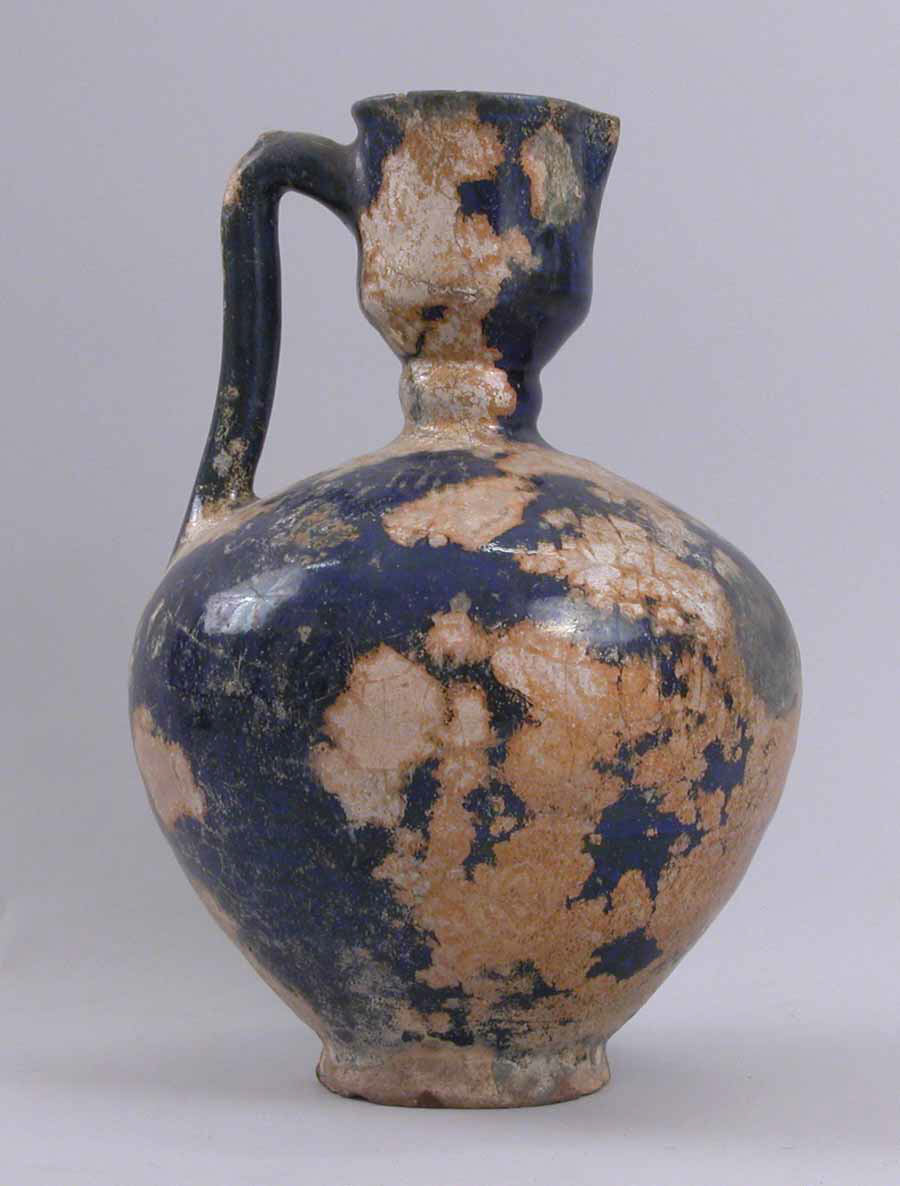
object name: ewer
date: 1201-1400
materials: earthenware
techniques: luster painting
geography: iran